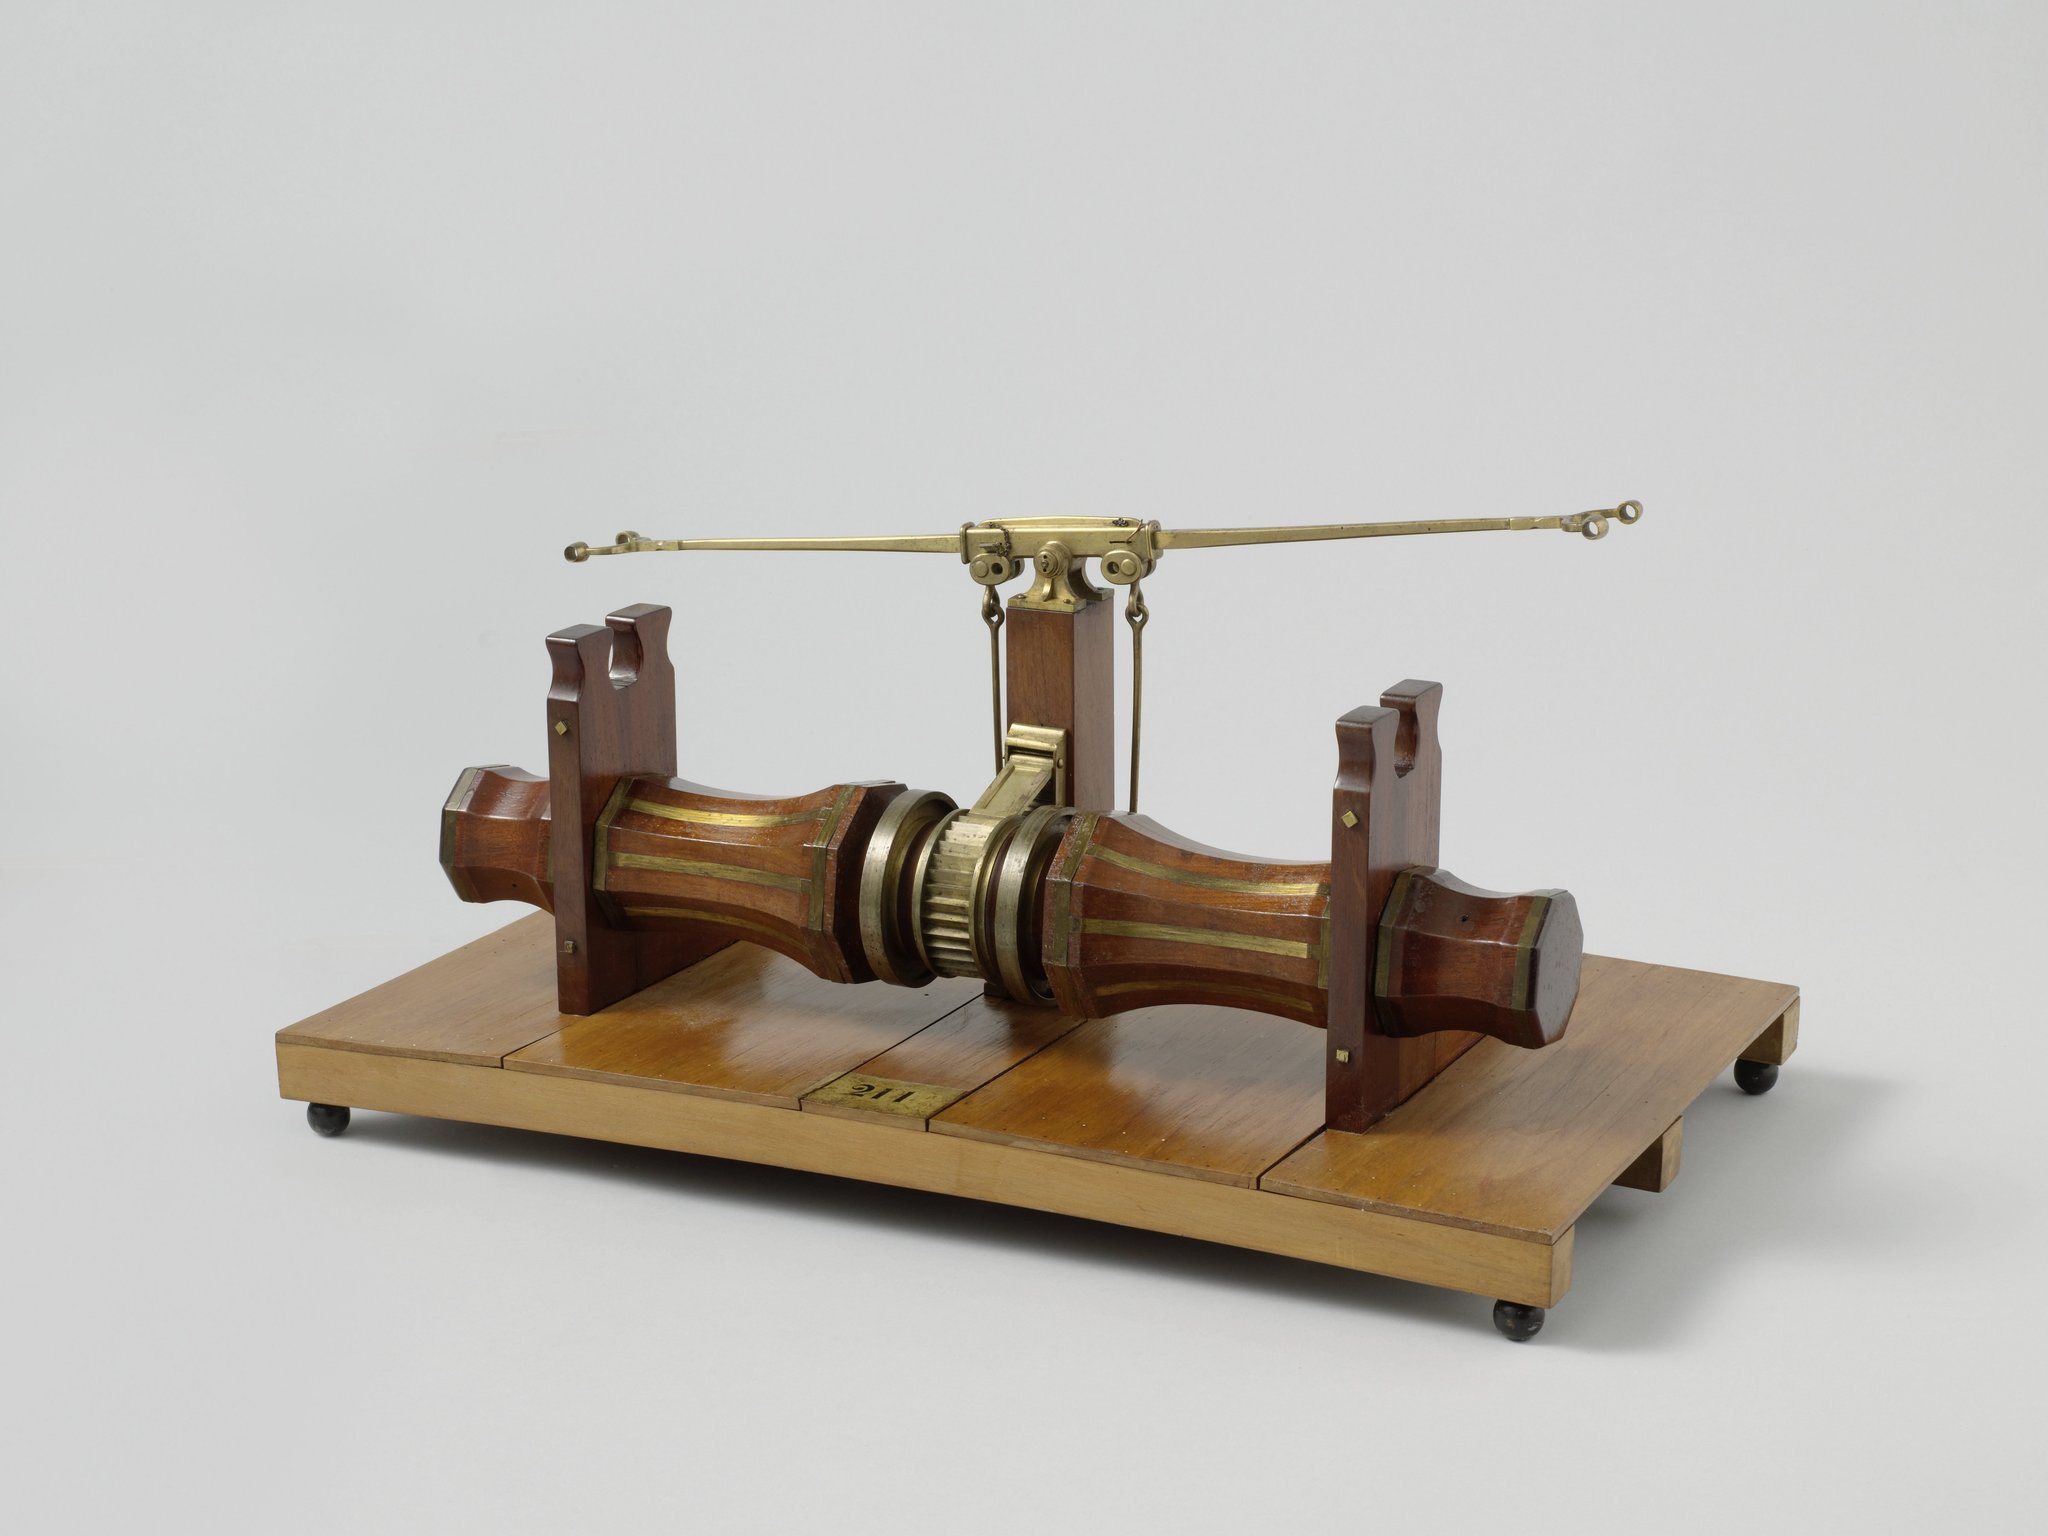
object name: demonstration model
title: Model of a Pump Windlass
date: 1852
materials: brass, wood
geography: leiden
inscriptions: label, on the base: ‘211’ former inventory label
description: Model van een braadspil op een vloerplank. De achthoekige trommel, opgehangen tussen twee wangen die de braadspilbeting vormen met twee knechten ieder, is ook voorzien van kleine trommels buiten de wangen. De braadspil wordt bediend met twee windbomen op een juk op de stut in het midden: rond de trommel lopen twee rails, waarop rem-mechanieken lopen die blokkeren bij een opwaartse beweging en vrij zijn als zij vallen, en die ieder aan een zijde van het juk verbonden zijn. De verbindingsstangen tussen juk en rem-mechanieken kunnen in twee standen gezet worden voor twee krachten. De stut in het midden heeft ook vijf metalen pallen, die in het tandwielgedeelte van de trommel grijpen om het teruglopen te voorkomen. De wangen kunnen ieder in twee helften uiteengenomen worden. Schaal 1:10 (schatting).